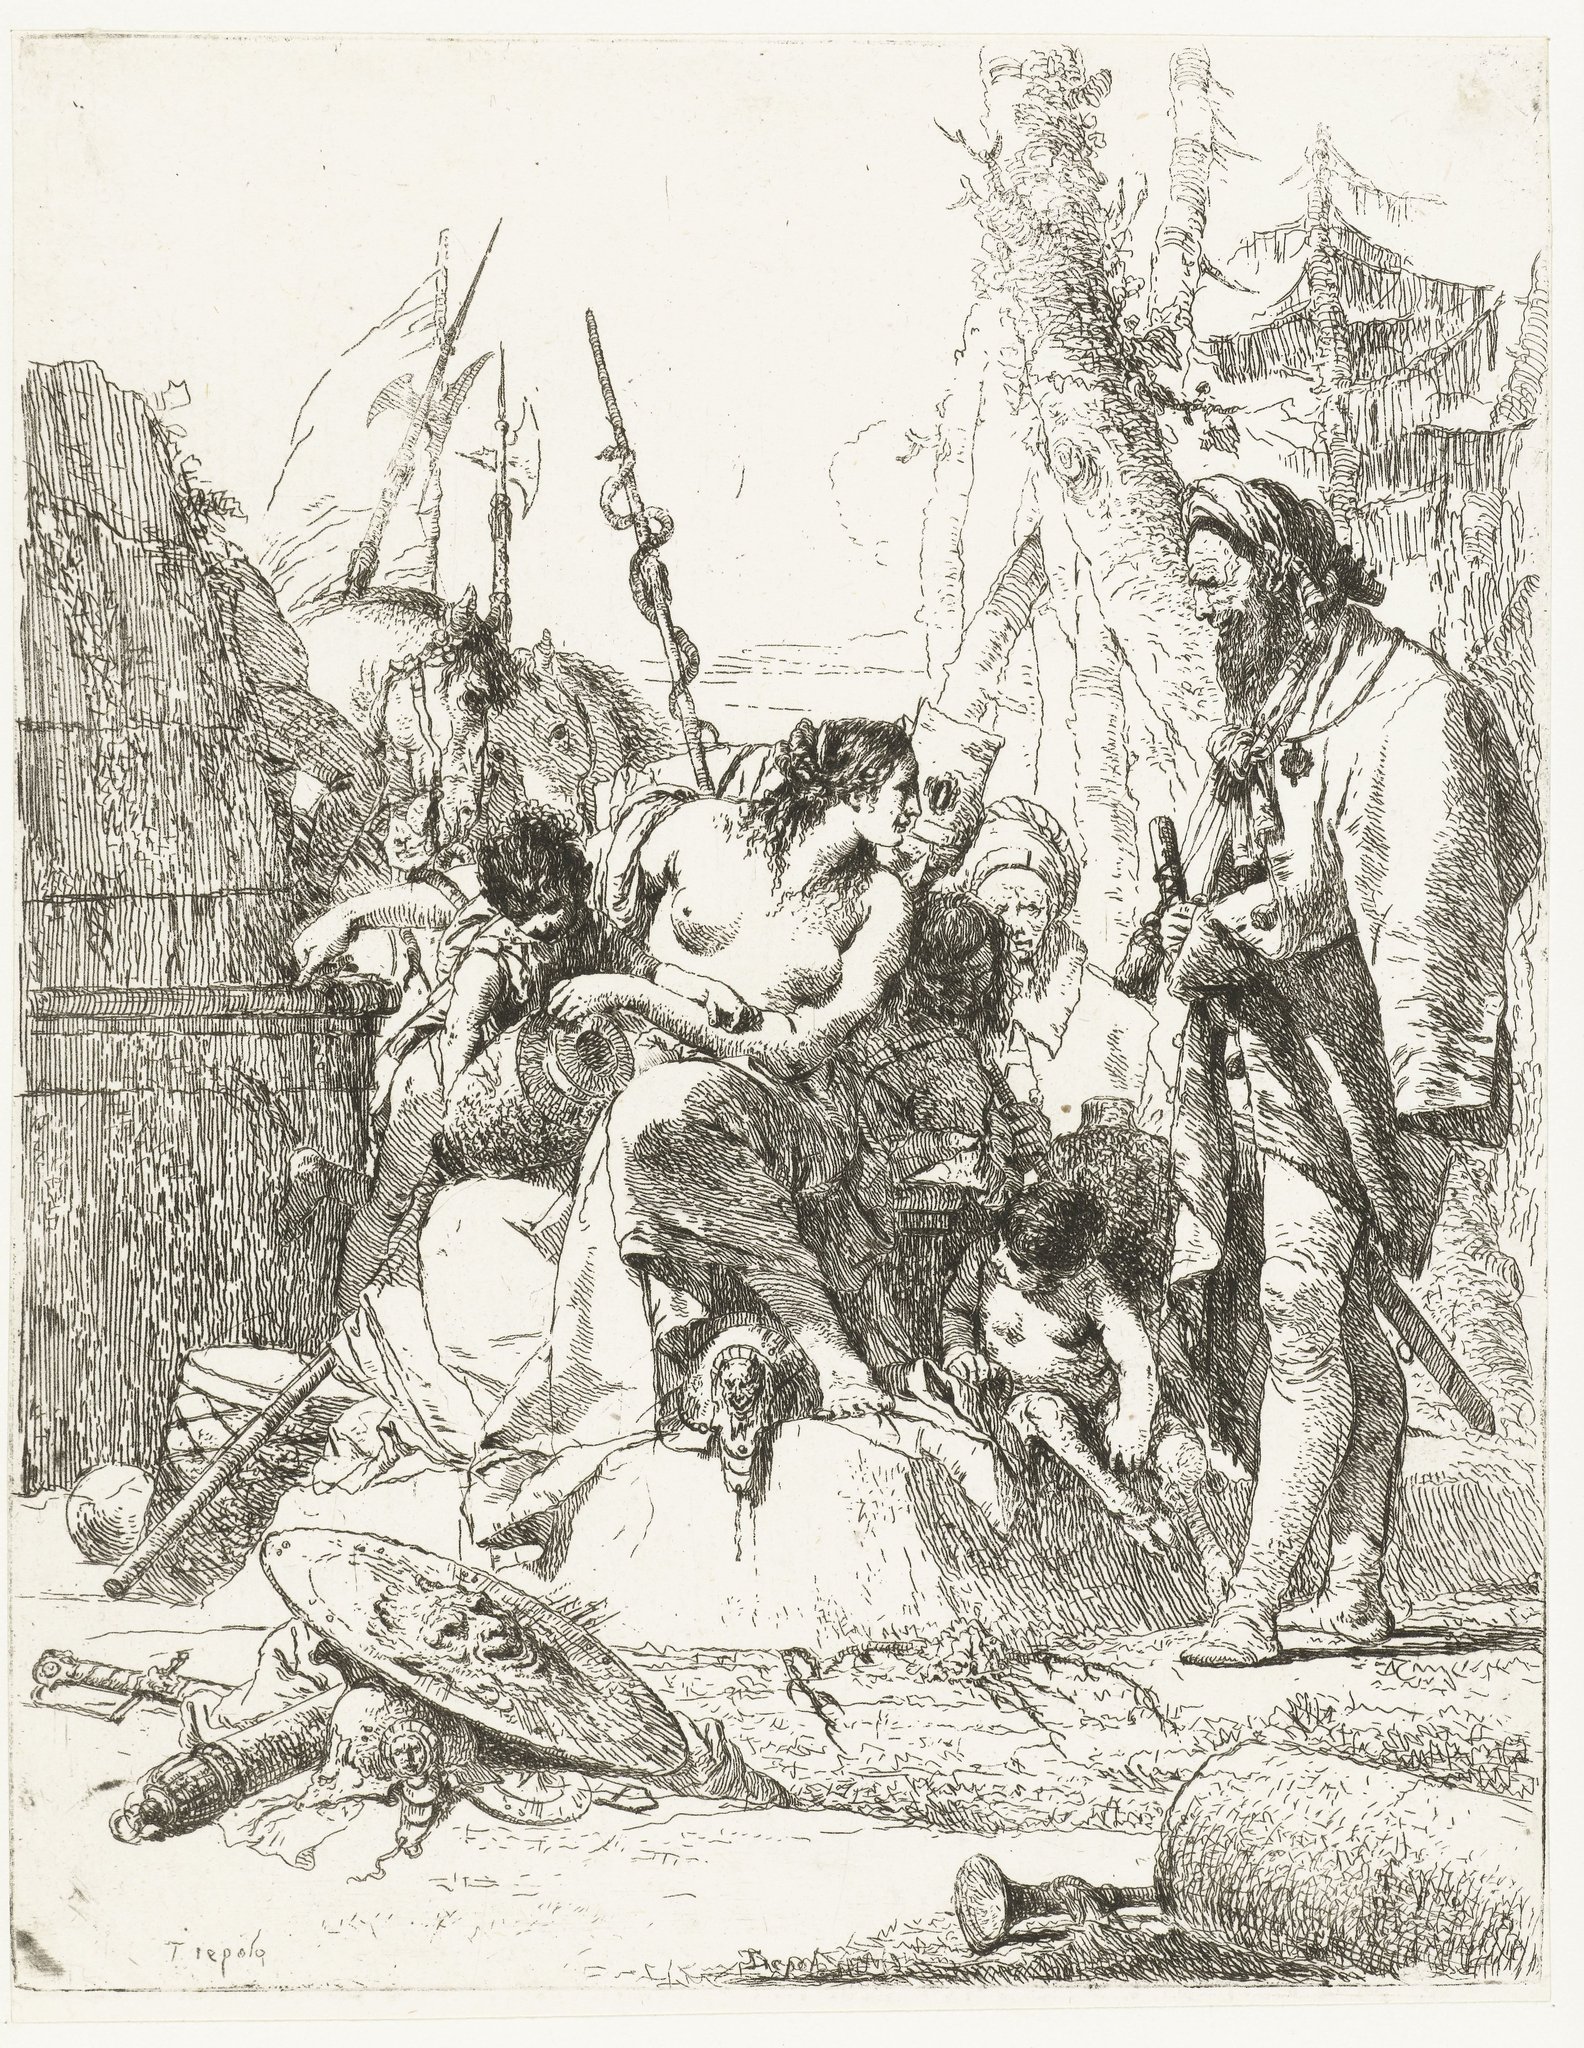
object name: print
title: Scherzi di fantasia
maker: giovanni battista tiepolo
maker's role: draughtsman, painter, print maker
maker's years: 1696-1770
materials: paper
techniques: etching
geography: italy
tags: satyr(s) (in general)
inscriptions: collector's mark: Lugt 2228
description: Prent maakt deel uit van serie met drieëntwintig prenten, bekend als Scherzi di fantasia. Na Giovanni Battista Tiepolo's dood werden de prenten in wisselende samenstellingen tot twee keer toe uitgegeven door zijn zoon, Giovanni Domenico. De serie in de collectie van het RMA is gedrukt in de eerste staat voor deze uitgaven, herkenbaar aan het ontbreken van een nummering.